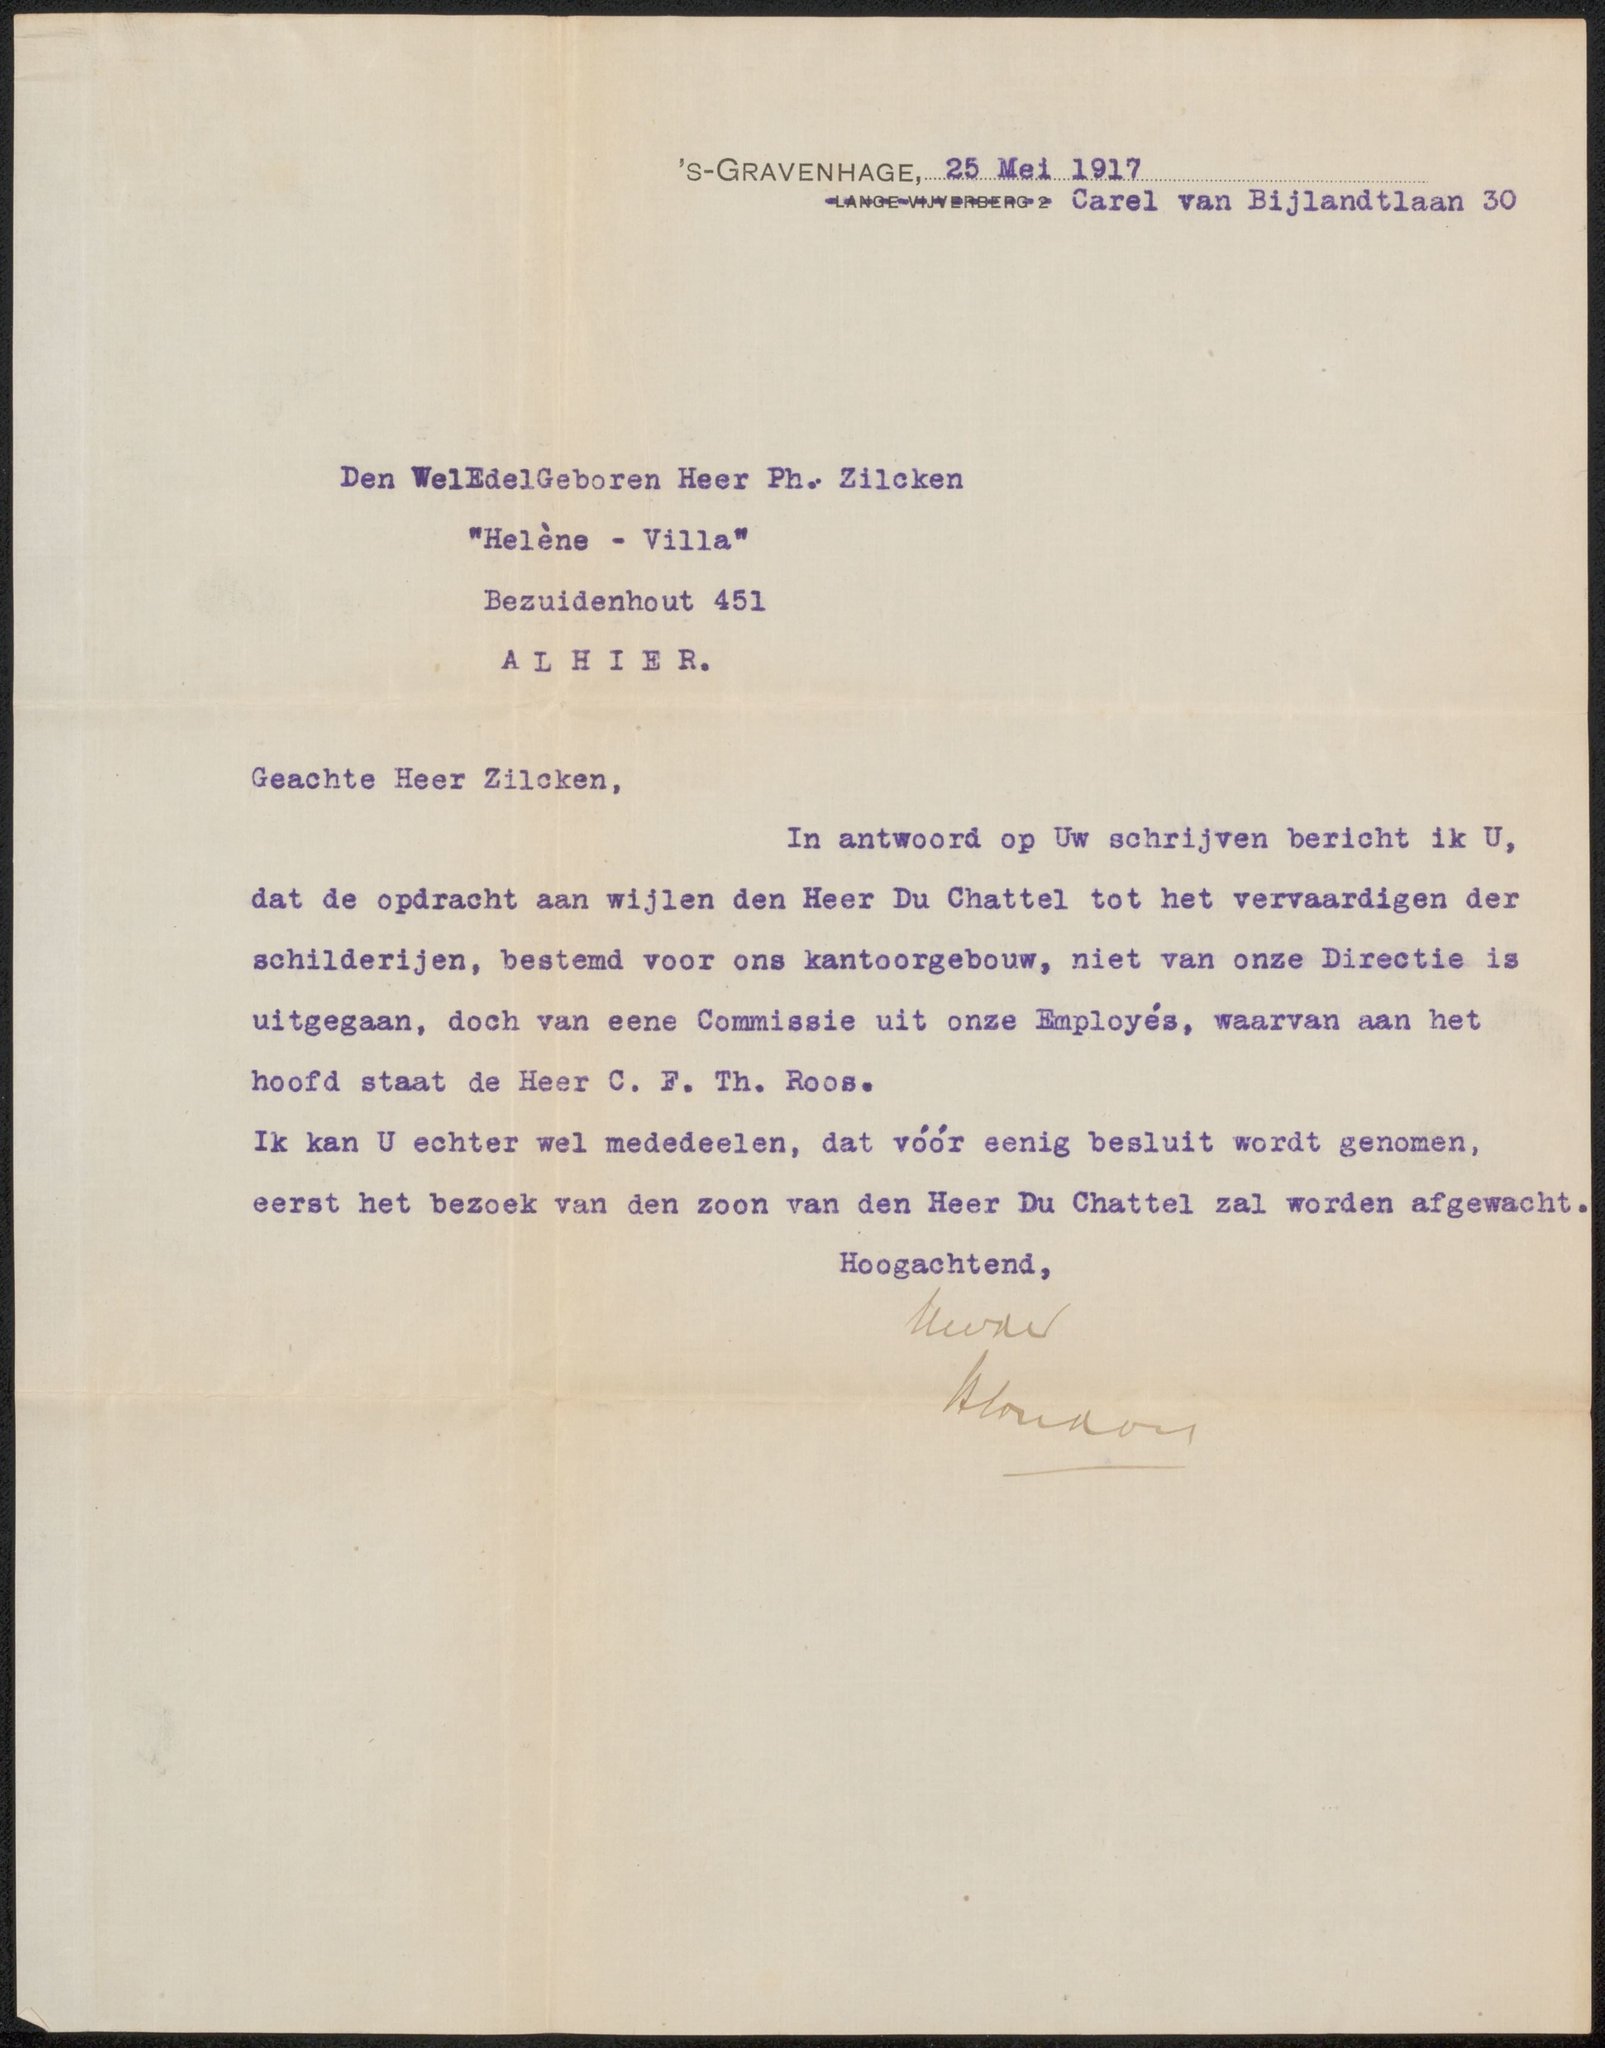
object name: letter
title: Brief aan Philip Zilcken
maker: hugo loudon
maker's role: civiel ingenieur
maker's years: 1860-1941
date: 1917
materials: ink, paper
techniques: pen, printing, typewriting, writing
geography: the hague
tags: leiden, painter, print maker, draughtsman, fredericus jacobus van rossum du chattel, philip zilcken, painting (including book-illumination, miniature-painting)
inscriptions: collector's mark: ‘RPK’